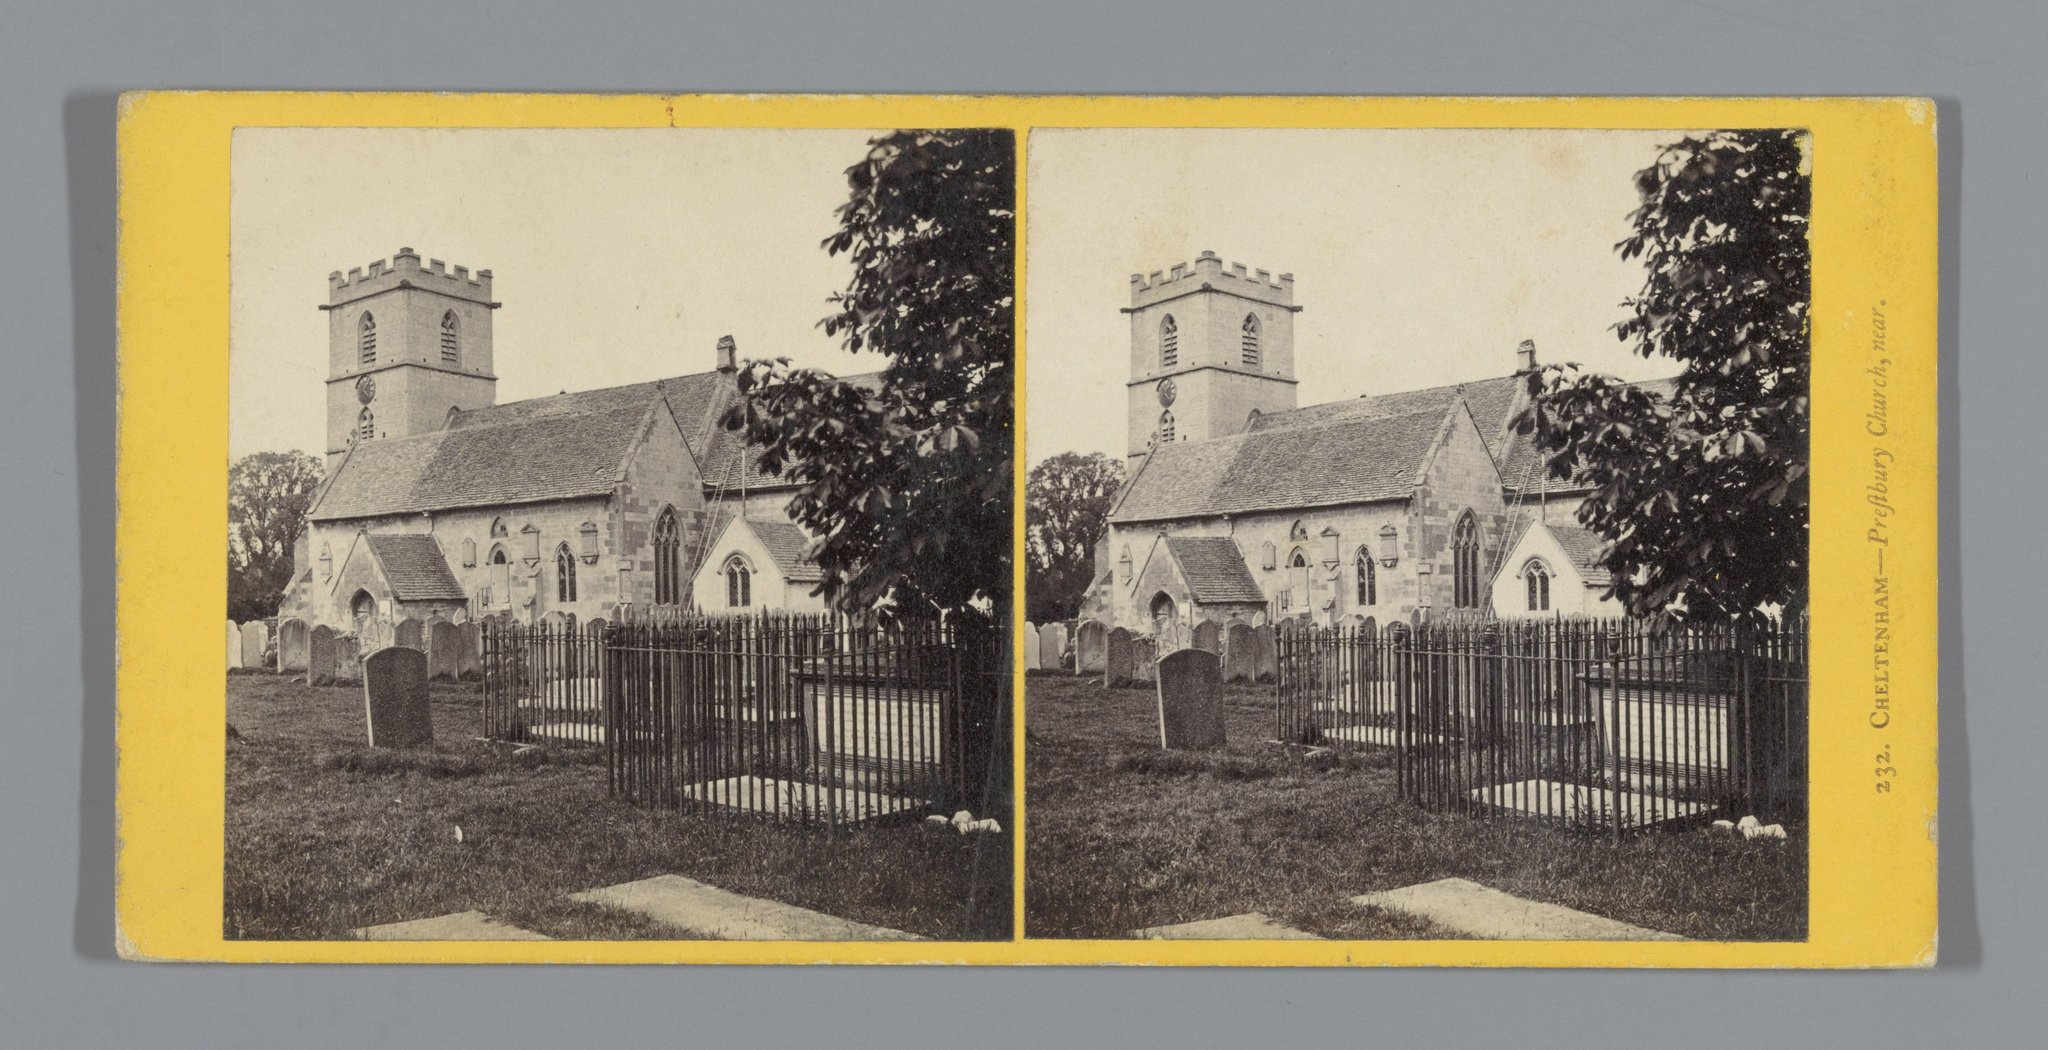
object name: stereograph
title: Gezicht op de Saint Mary's Church in Prestbury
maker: Anonymous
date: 1850-1880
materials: cardboard, photographic support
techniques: albumen print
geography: prestbury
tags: church (exterior)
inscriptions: number: ‘232.’